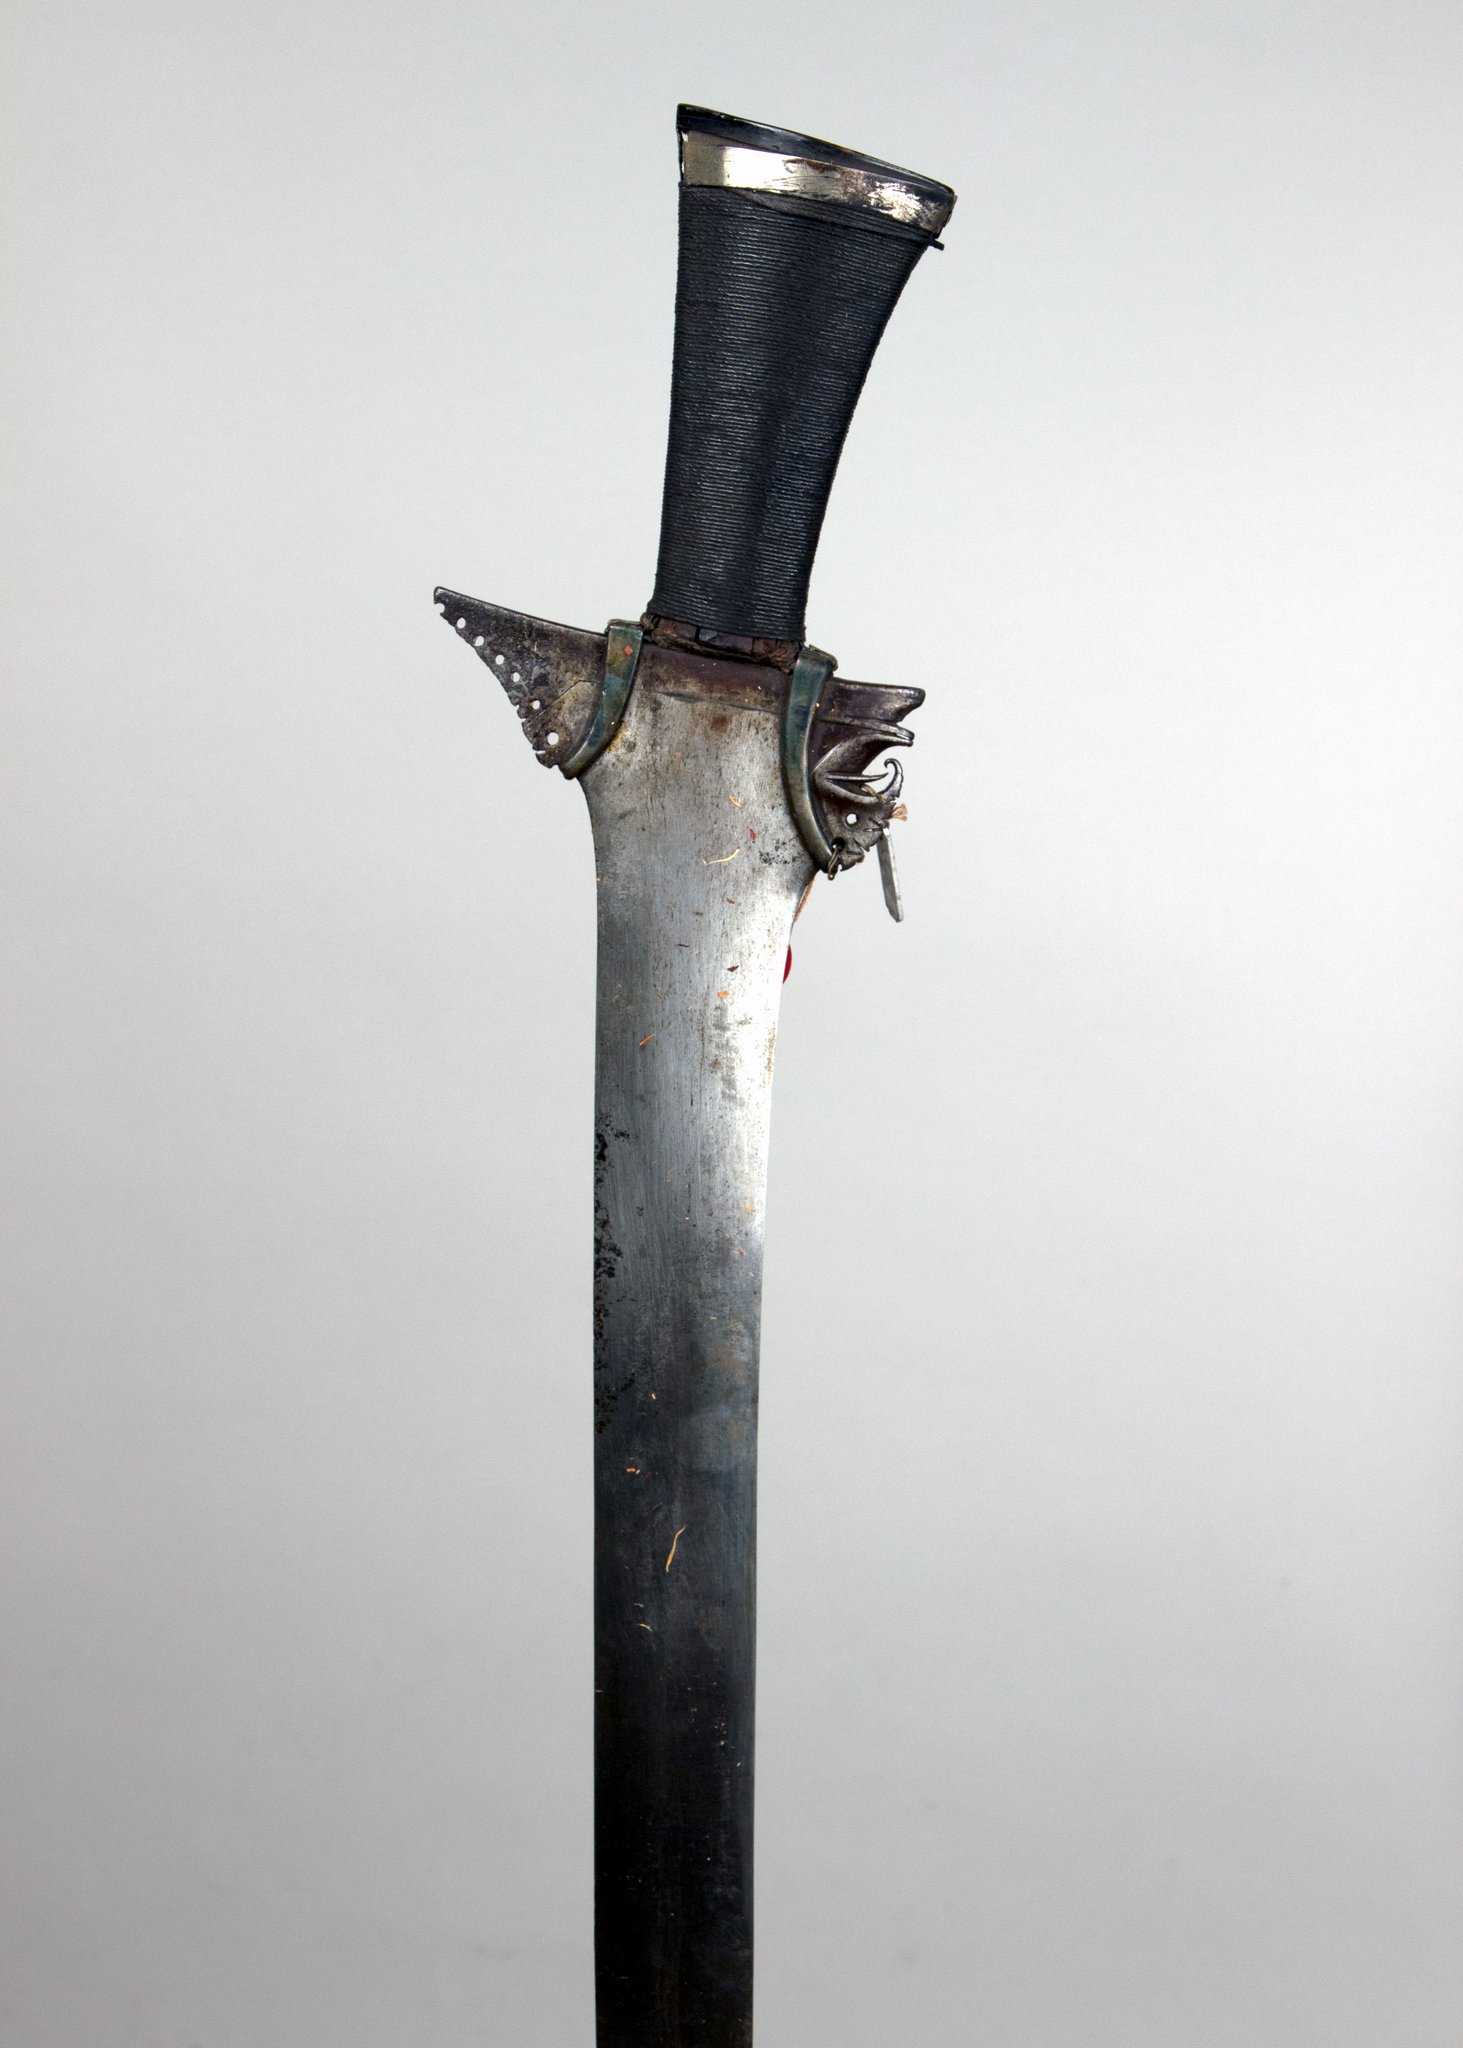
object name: kris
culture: philippine, moro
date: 1701-1900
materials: silver, steel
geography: philippines